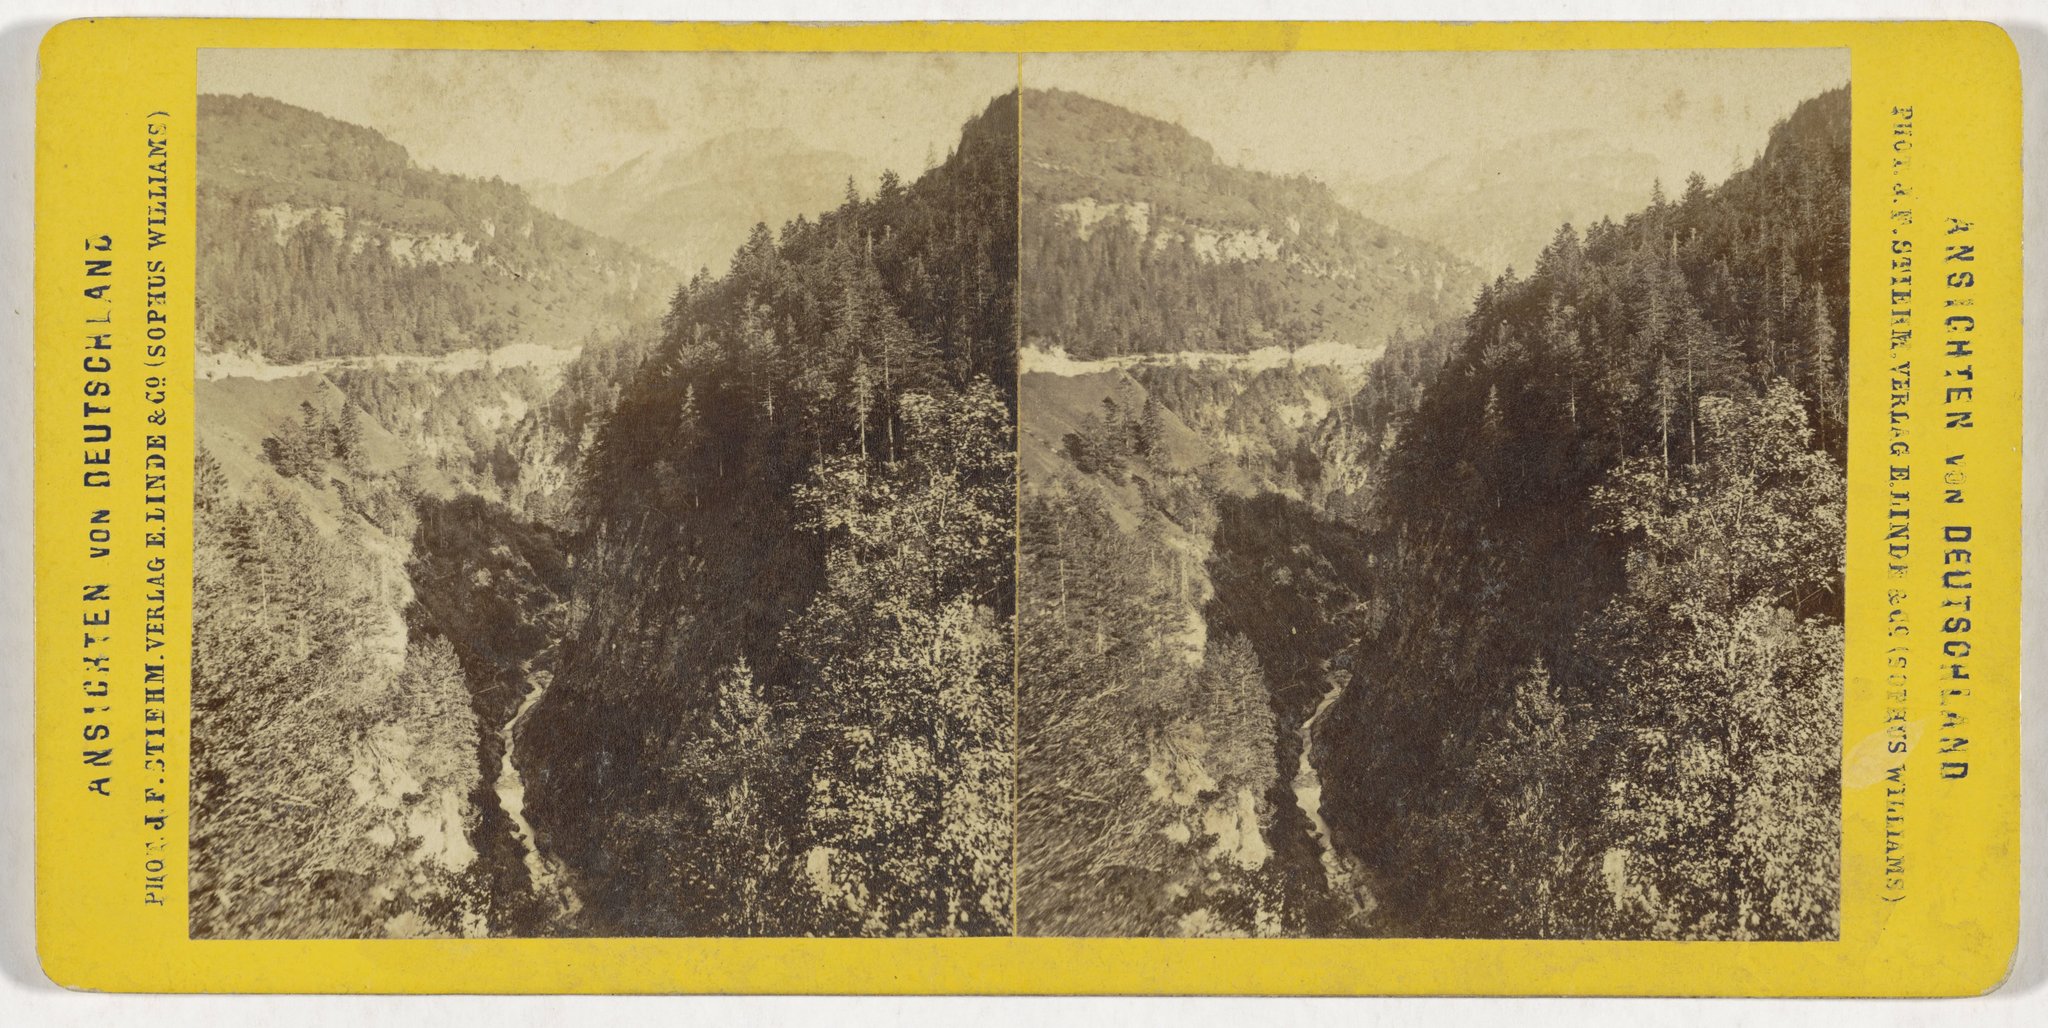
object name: stereograph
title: Ravijn en de rivier de Rote Traun in Beieren, Duitsland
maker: johann friedrich stiehm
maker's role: fotograaf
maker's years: 1826-1902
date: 1868-1900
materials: cardboard, paper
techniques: albumen print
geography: london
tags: dale, valley, ravine, chasm, abyss, canyon, forest, wood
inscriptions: number: ‘No. 128.’, inscription: ‘U. No. 18’, inscription: ‘No 5300’